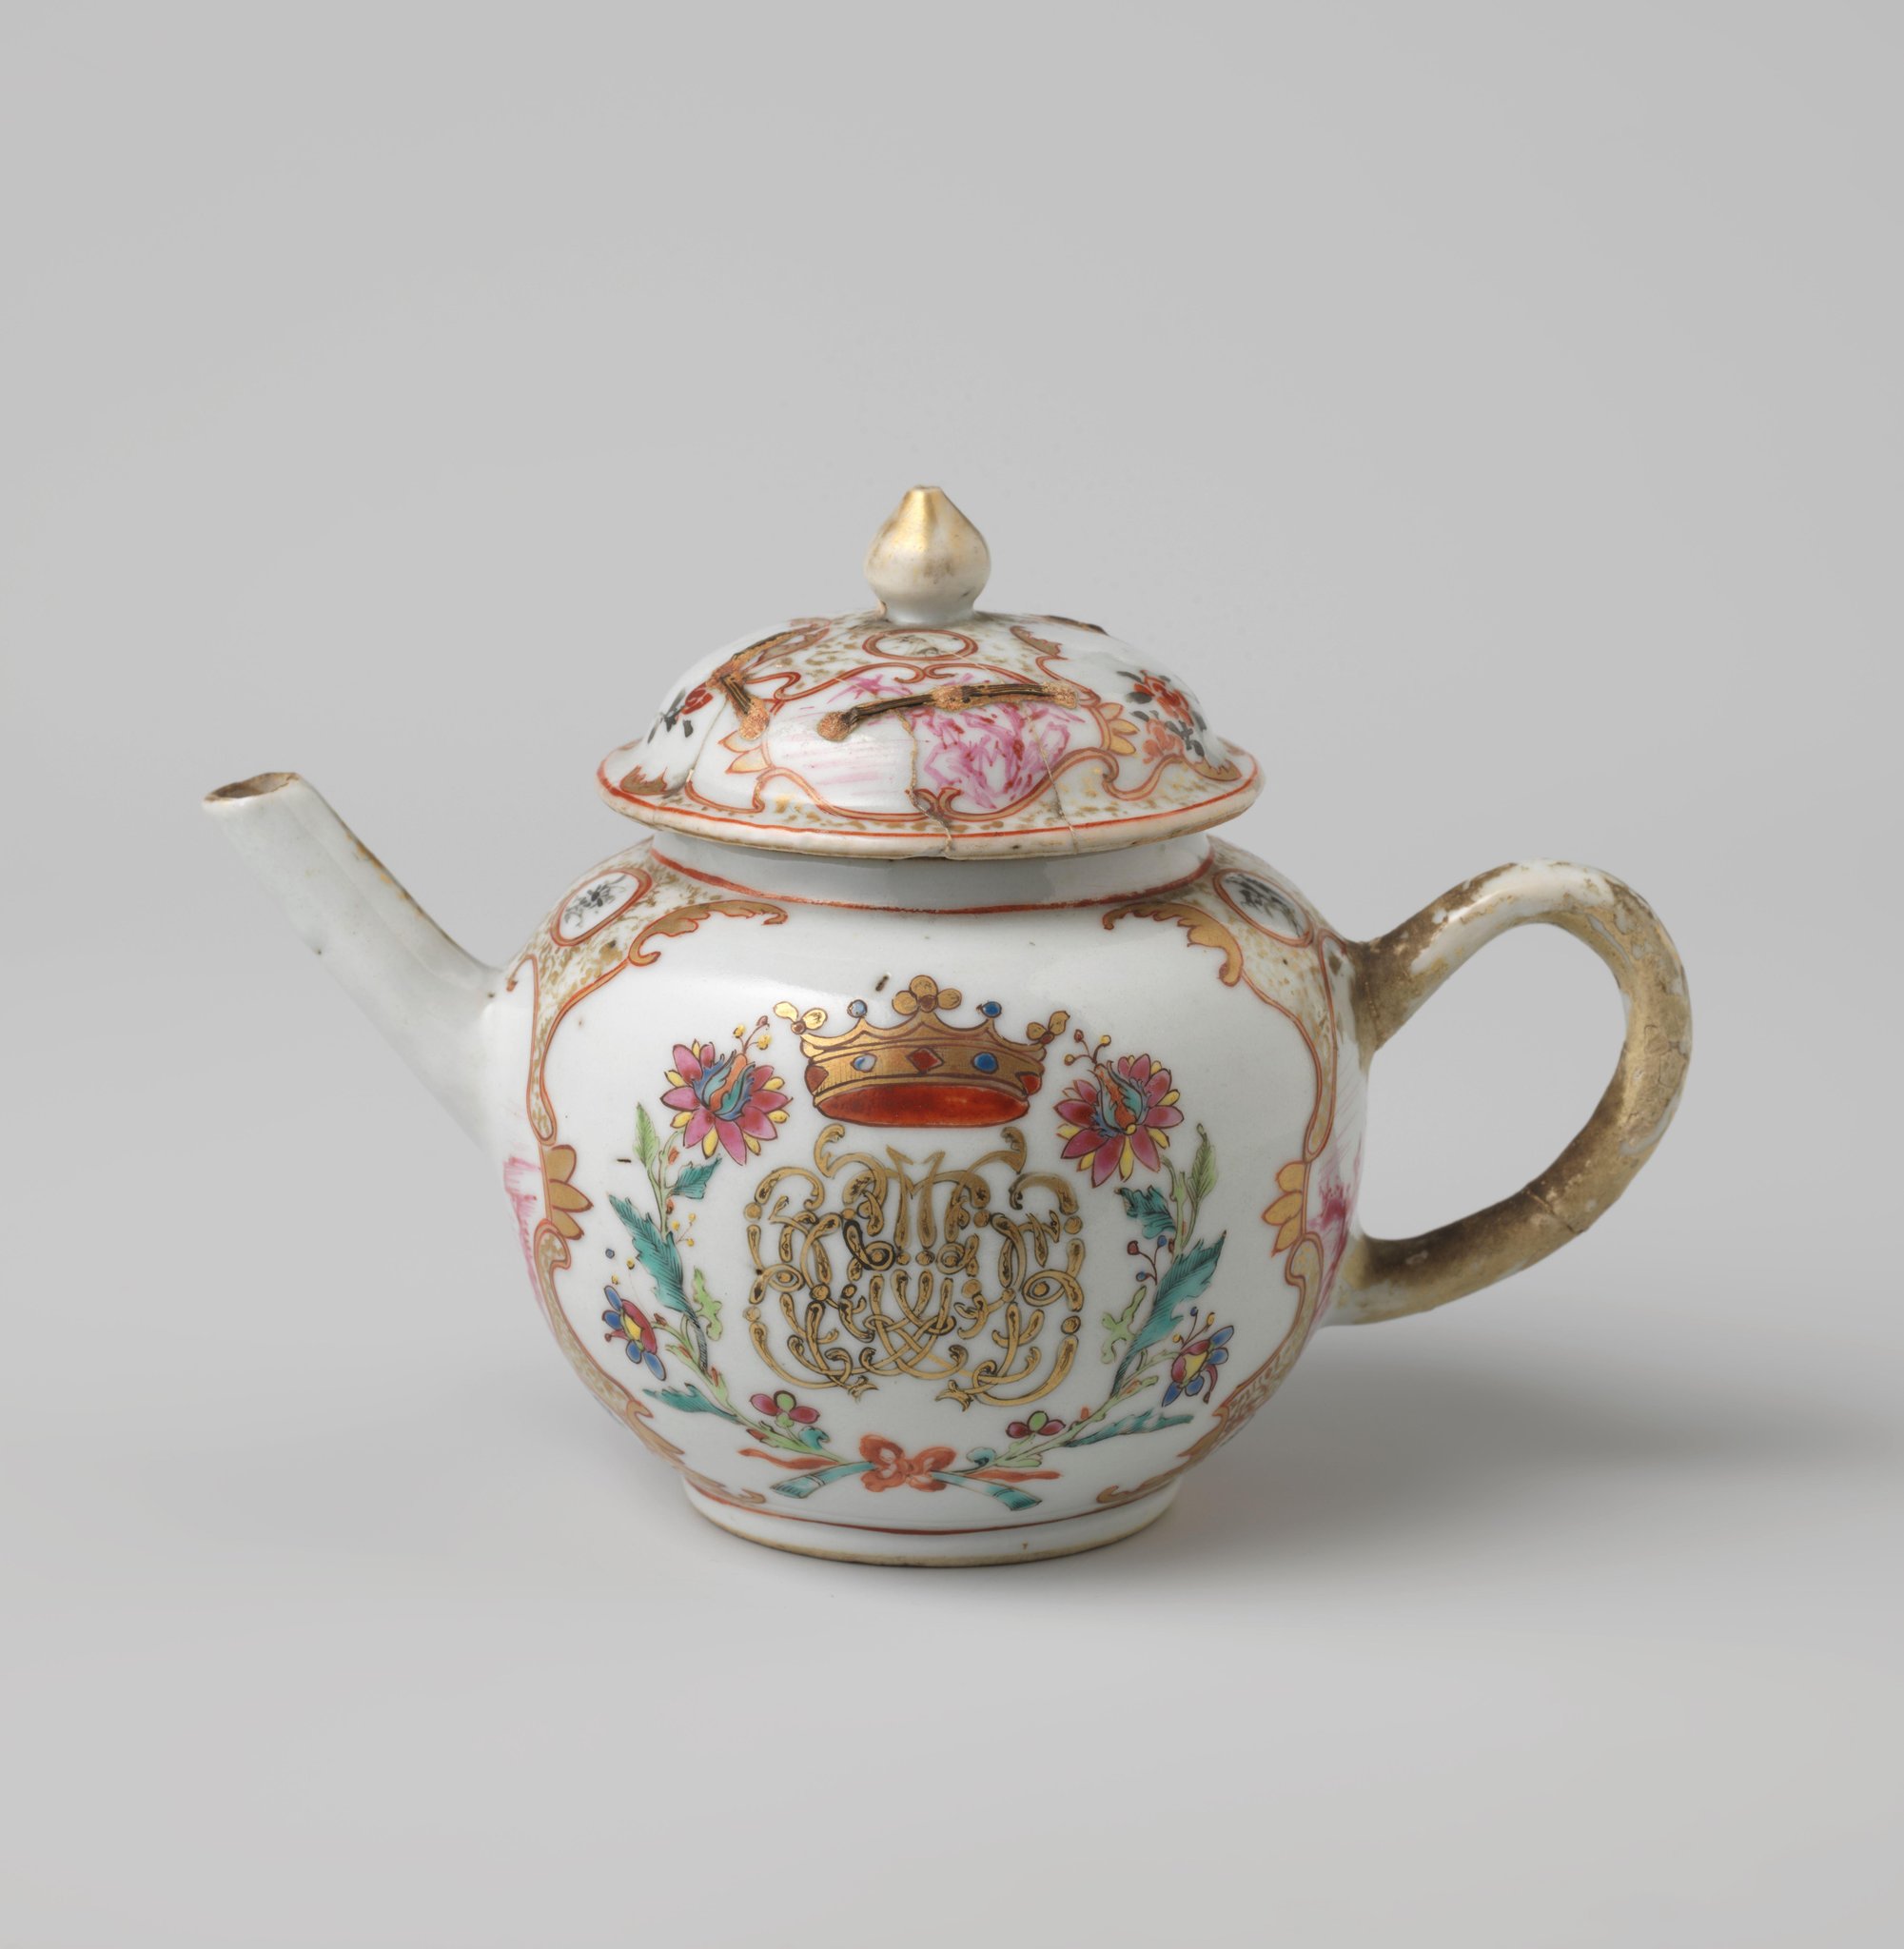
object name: teapot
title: Teapot with a crowned, illegible monogram surrounded by two flower sprays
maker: Anonymous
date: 1750-1774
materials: glaze, gold, paint, porcelain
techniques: firing, forming, gilding, turning, vitrification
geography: china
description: Deksel van theepot van porselein met bolvormig lichaam, c-vormig oor en rechte tuit, beschilderd op het glazuur in blauw, rood, roze, groen, geel, zwart en goud. Op de deksel bloemranken en cartouches met landschappen of bloemtakken. Deksel en oor zijn gebroken geweest. Europese voorstelling in emailkleuren.